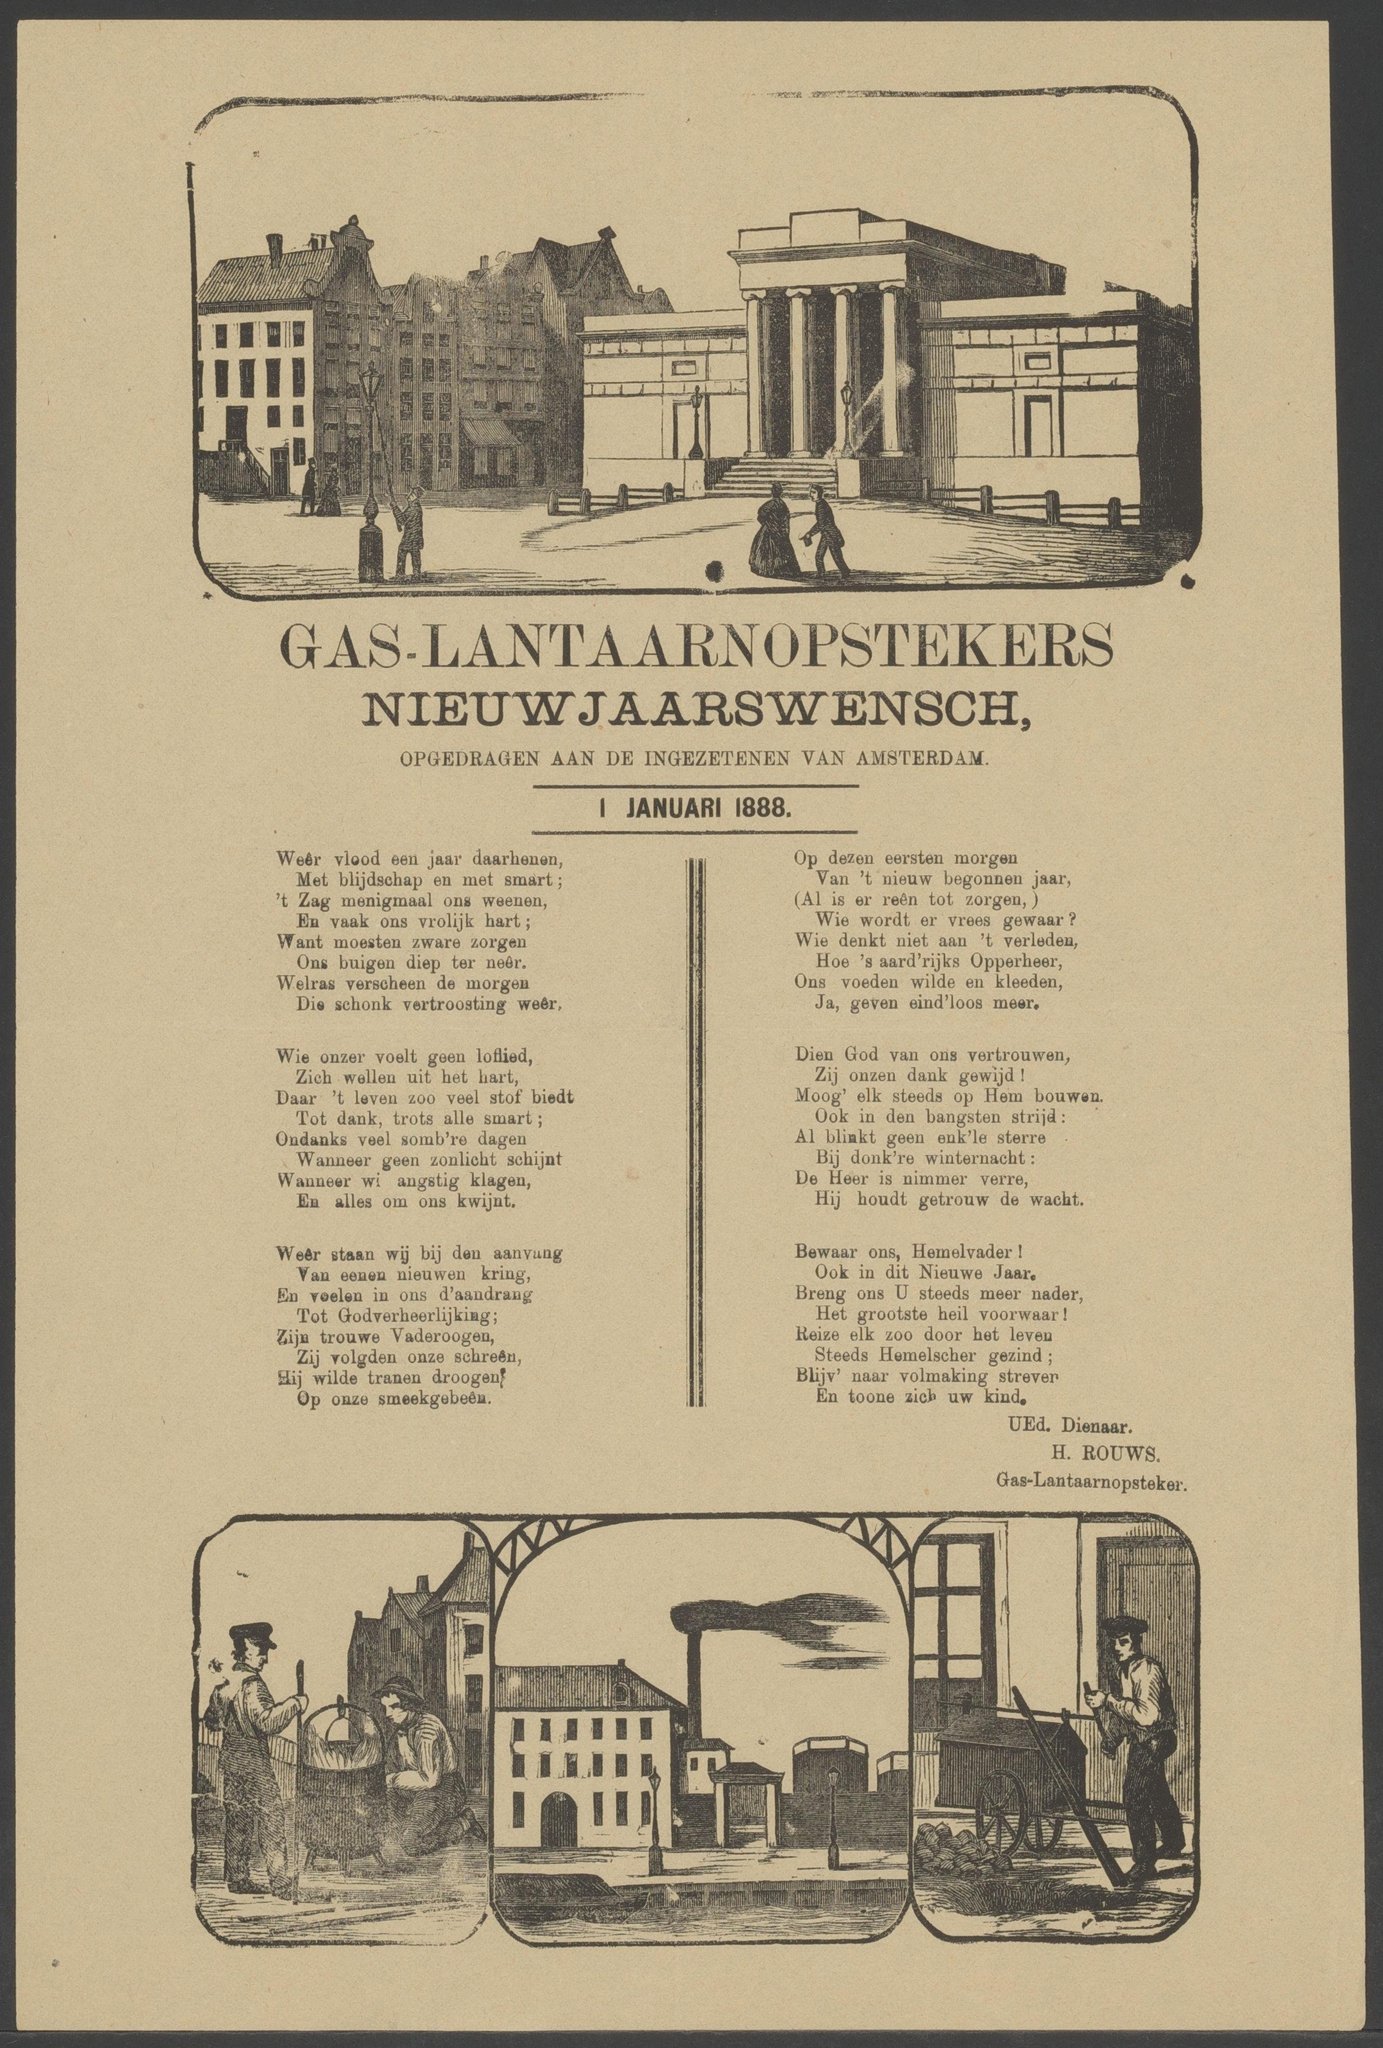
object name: print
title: Nieuwjaarswens van de gaslantaarnopstekers van Amsterdam voor het jaar 1888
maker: Anonymous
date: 1887-1888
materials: paper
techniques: letterpress printing, engraving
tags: gas-lamp, gas supply, digging (industrial process), street lighting, amsterdam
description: Nieuwjaarswens van de Amsterdamse gaslantaarnopstekers voor het jaar 1888. Centraal een vers in twee kolommen. Bovenaan de Dam met de beurs van Zocher te Amsterdam. Onderaan de Hollandsche Gasfabriek en twee gasfitters aan het werk. Van de gaslantaarnopsteker: H. Rouws. Onderwerpsrubrieken binnen de Atlas Zeden en Gewoonten: Zeden en gewoonten in engeren zin, Volksleven, Volksbladen, Nieuwjaars- en Kerstwenschen, Amsterdam.